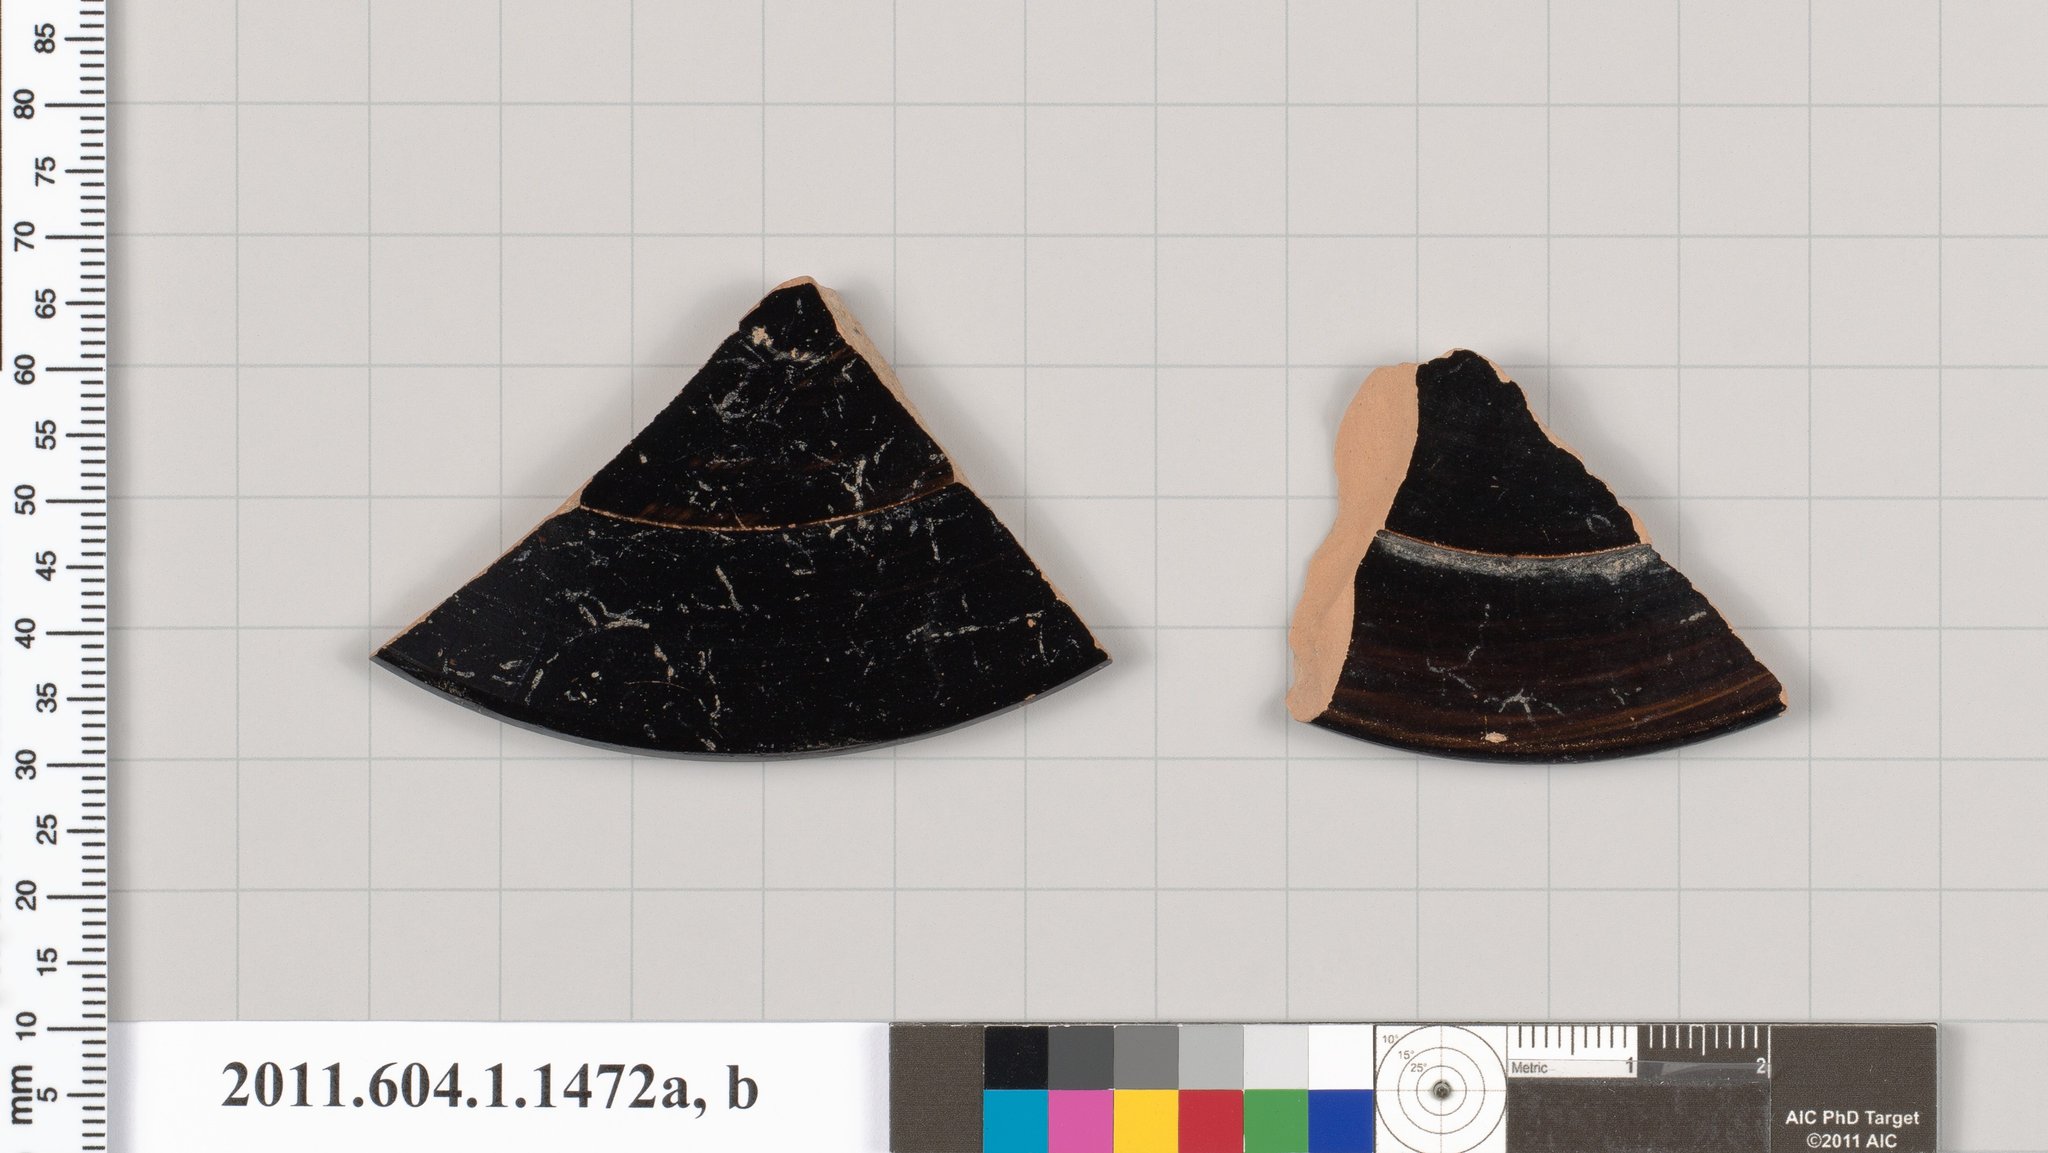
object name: kylix fragment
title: Terracotta fragments of kylikes (drinking cups)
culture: greek, attic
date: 500-401 BCE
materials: terracotta